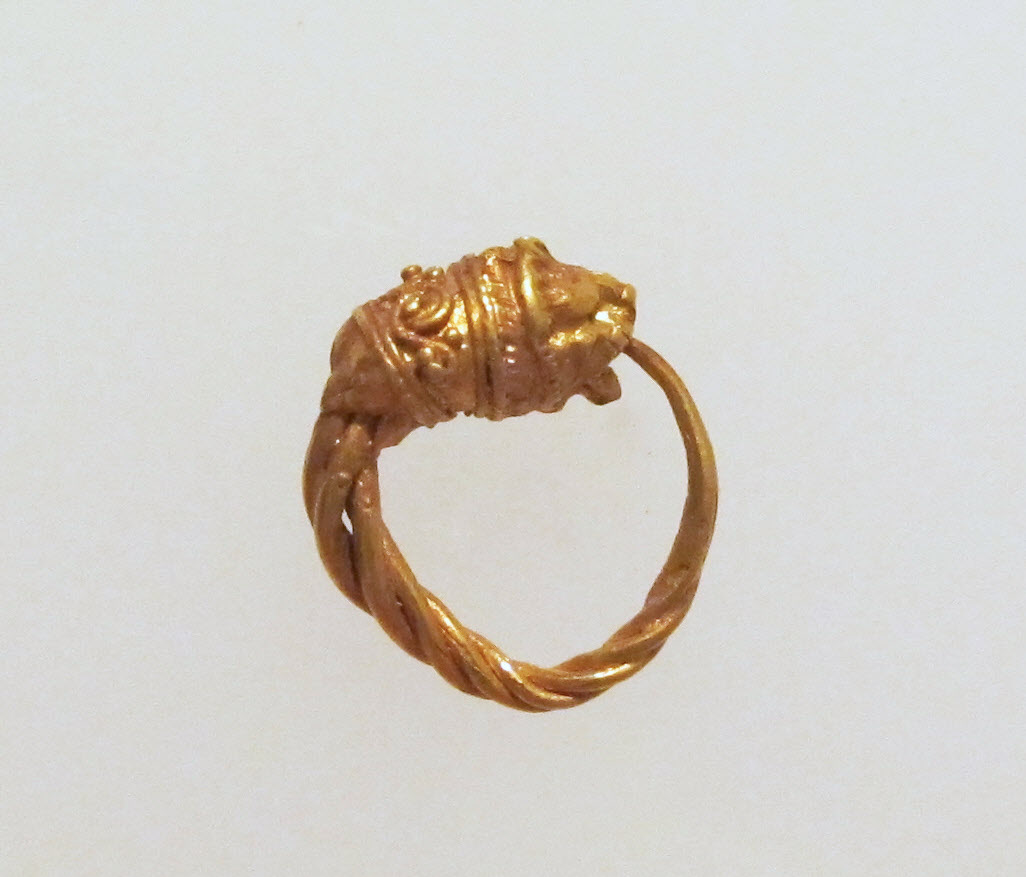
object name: earring with head of lion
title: Gold earring with head of a lion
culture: greek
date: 400-201 BCE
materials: gold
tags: lions